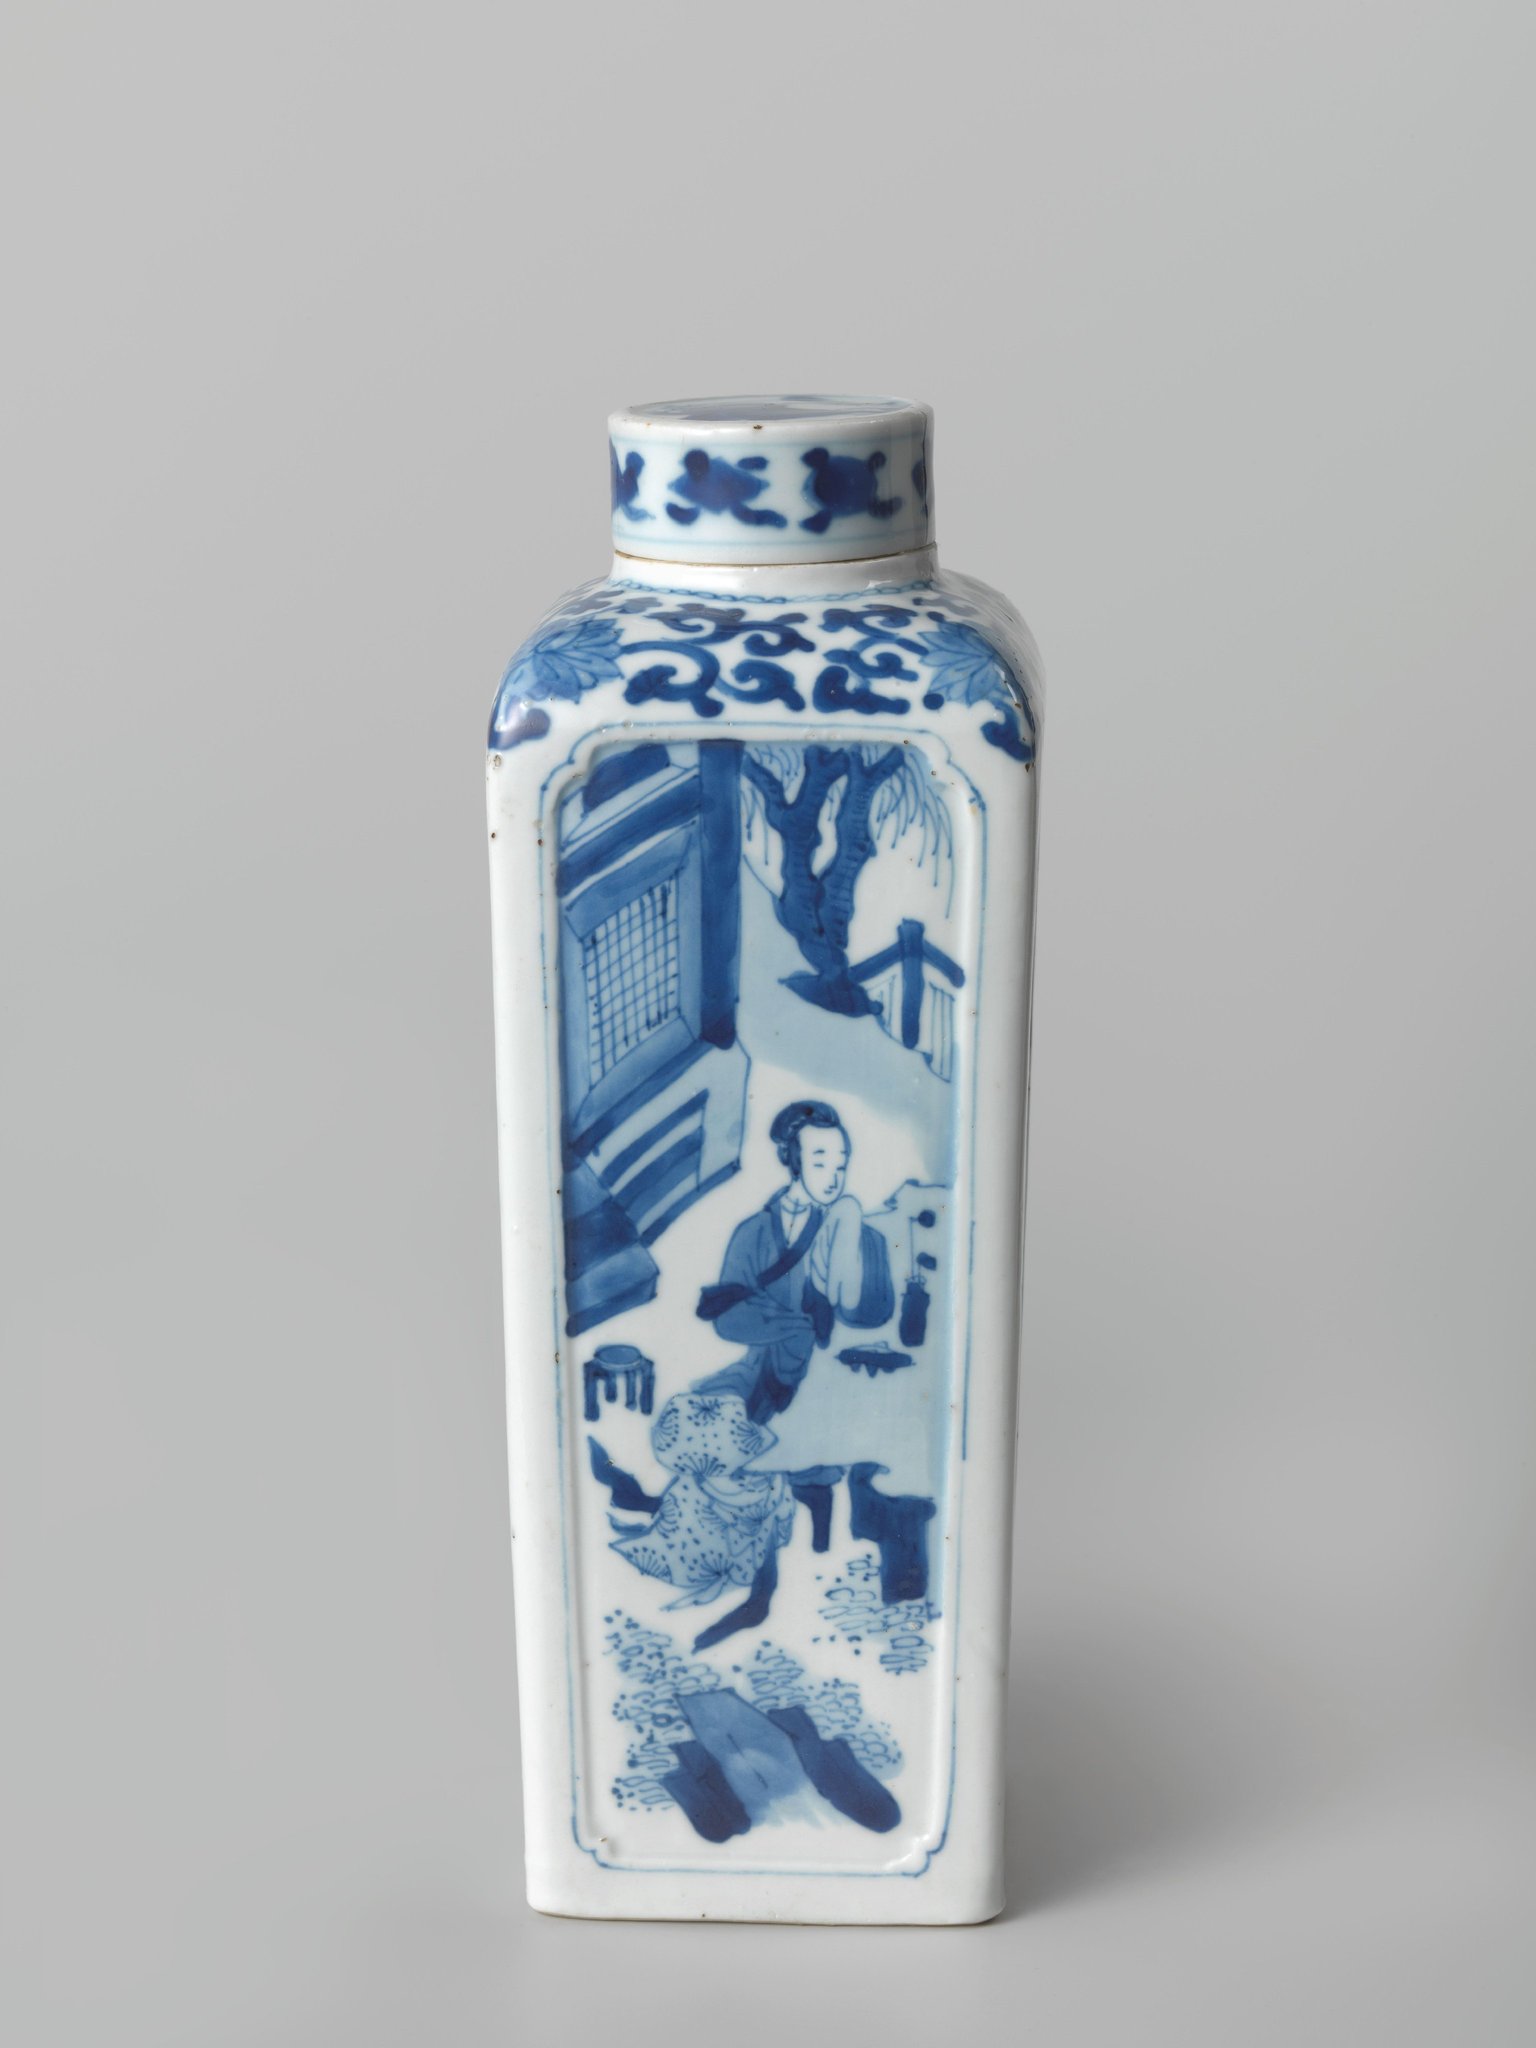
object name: pot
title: Square jar with women in a landscape or garden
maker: Anonymous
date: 1680-1720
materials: cobalt, glaze, paint, porcelain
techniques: forming, turning, vitrification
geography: china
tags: landscapes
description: Fles, vierkant, met vrouwenfiguur in een landschap op alle zijden.